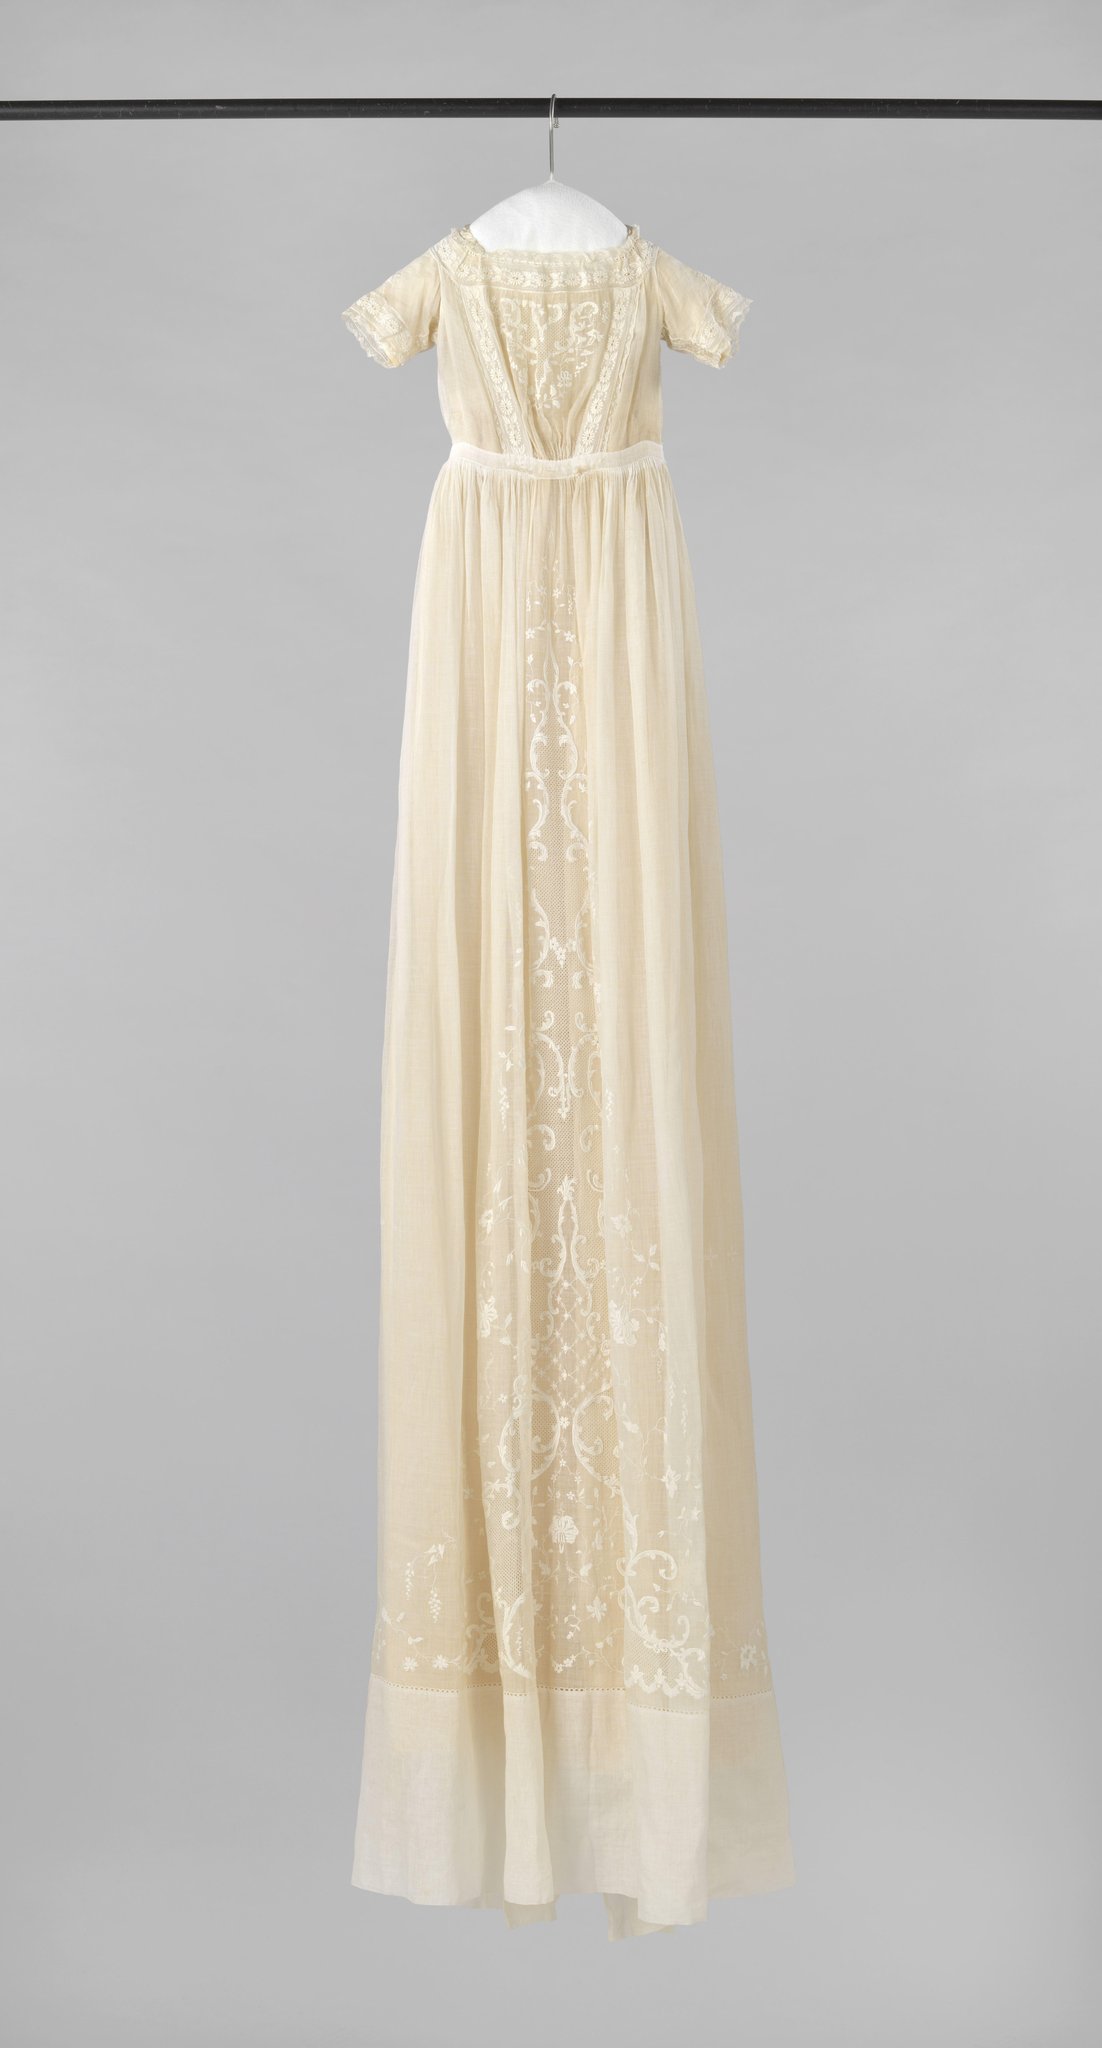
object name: childrenswear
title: Onderjurk van crème satijn, behorende bij doopjurk van batist met ajour borduurwerk.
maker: Anonymous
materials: silk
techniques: satin binding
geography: netherlands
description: Onderjurk van crème satijn, behorende bij doopjurk van batist met ajour borduurwerk (A).